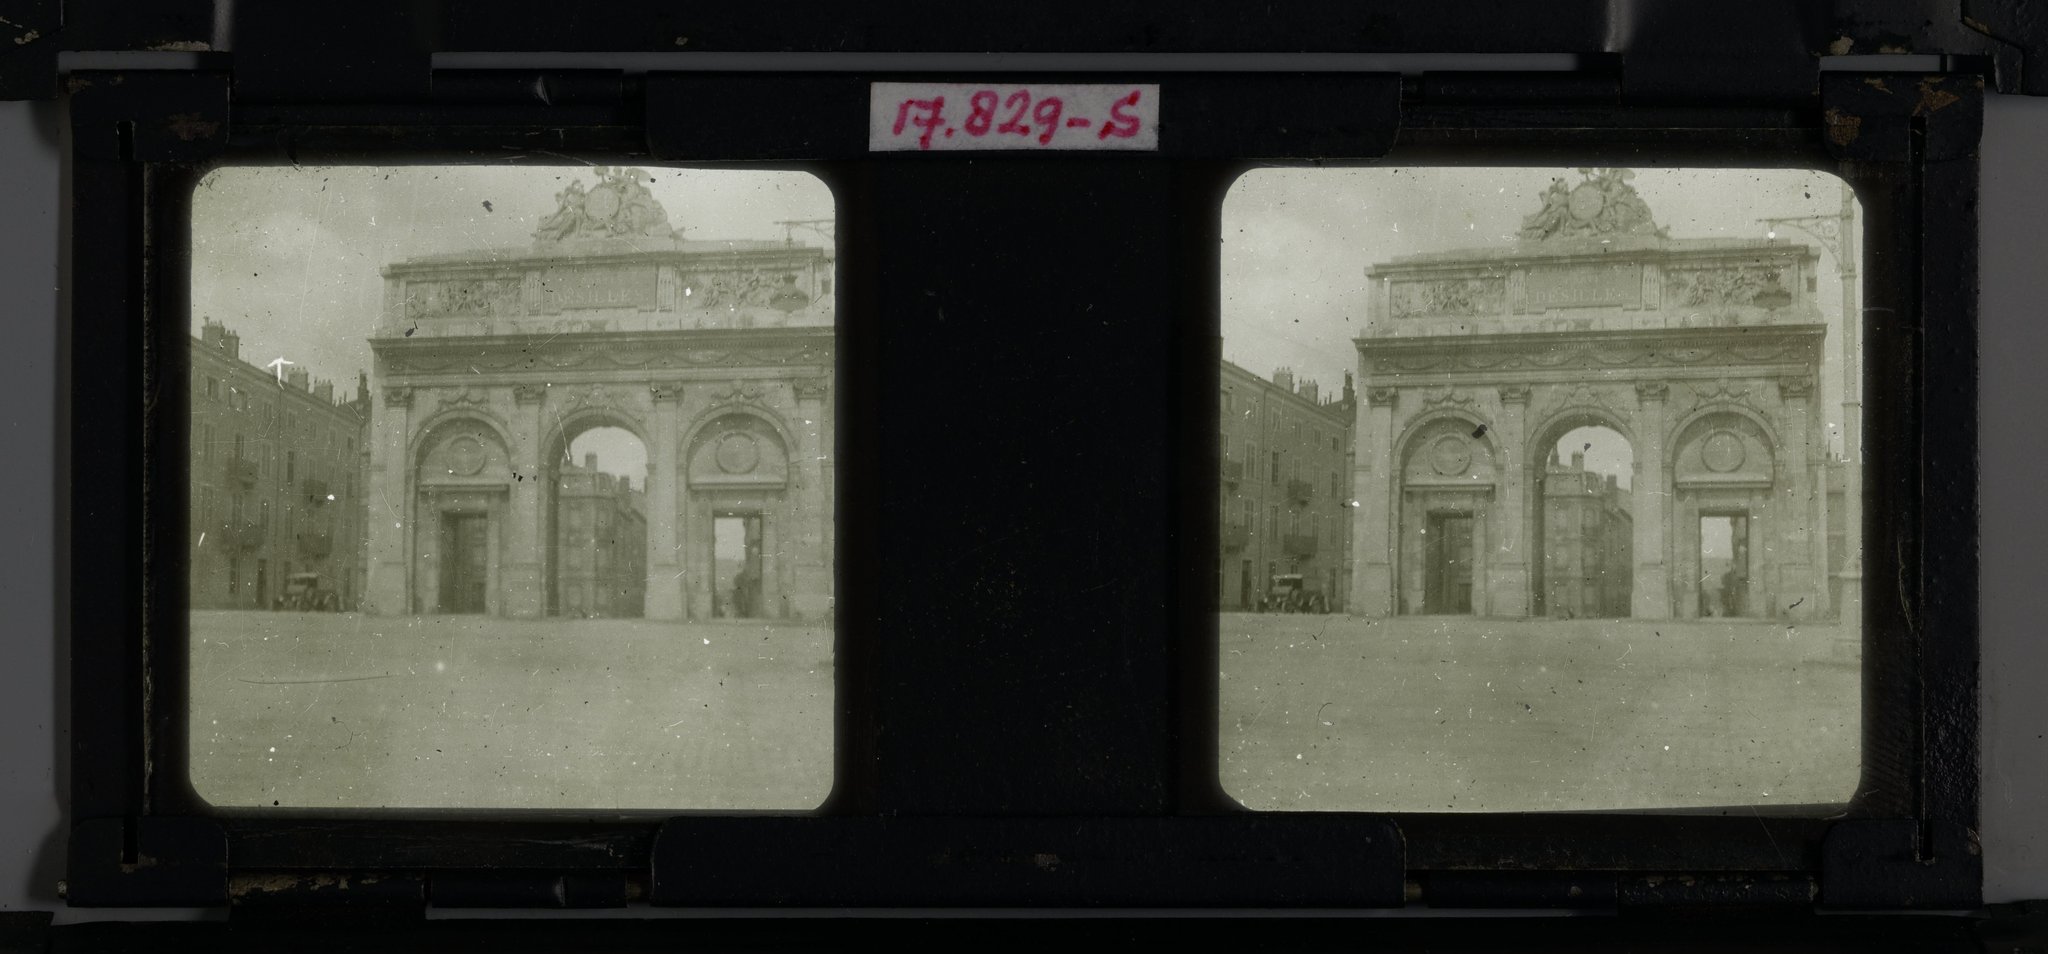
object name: stereoscopic photograph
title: Porte Désilles te Nancy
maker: Anonymous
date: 1924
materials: glass, metal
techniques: slide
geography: nancy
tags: triumphal arch